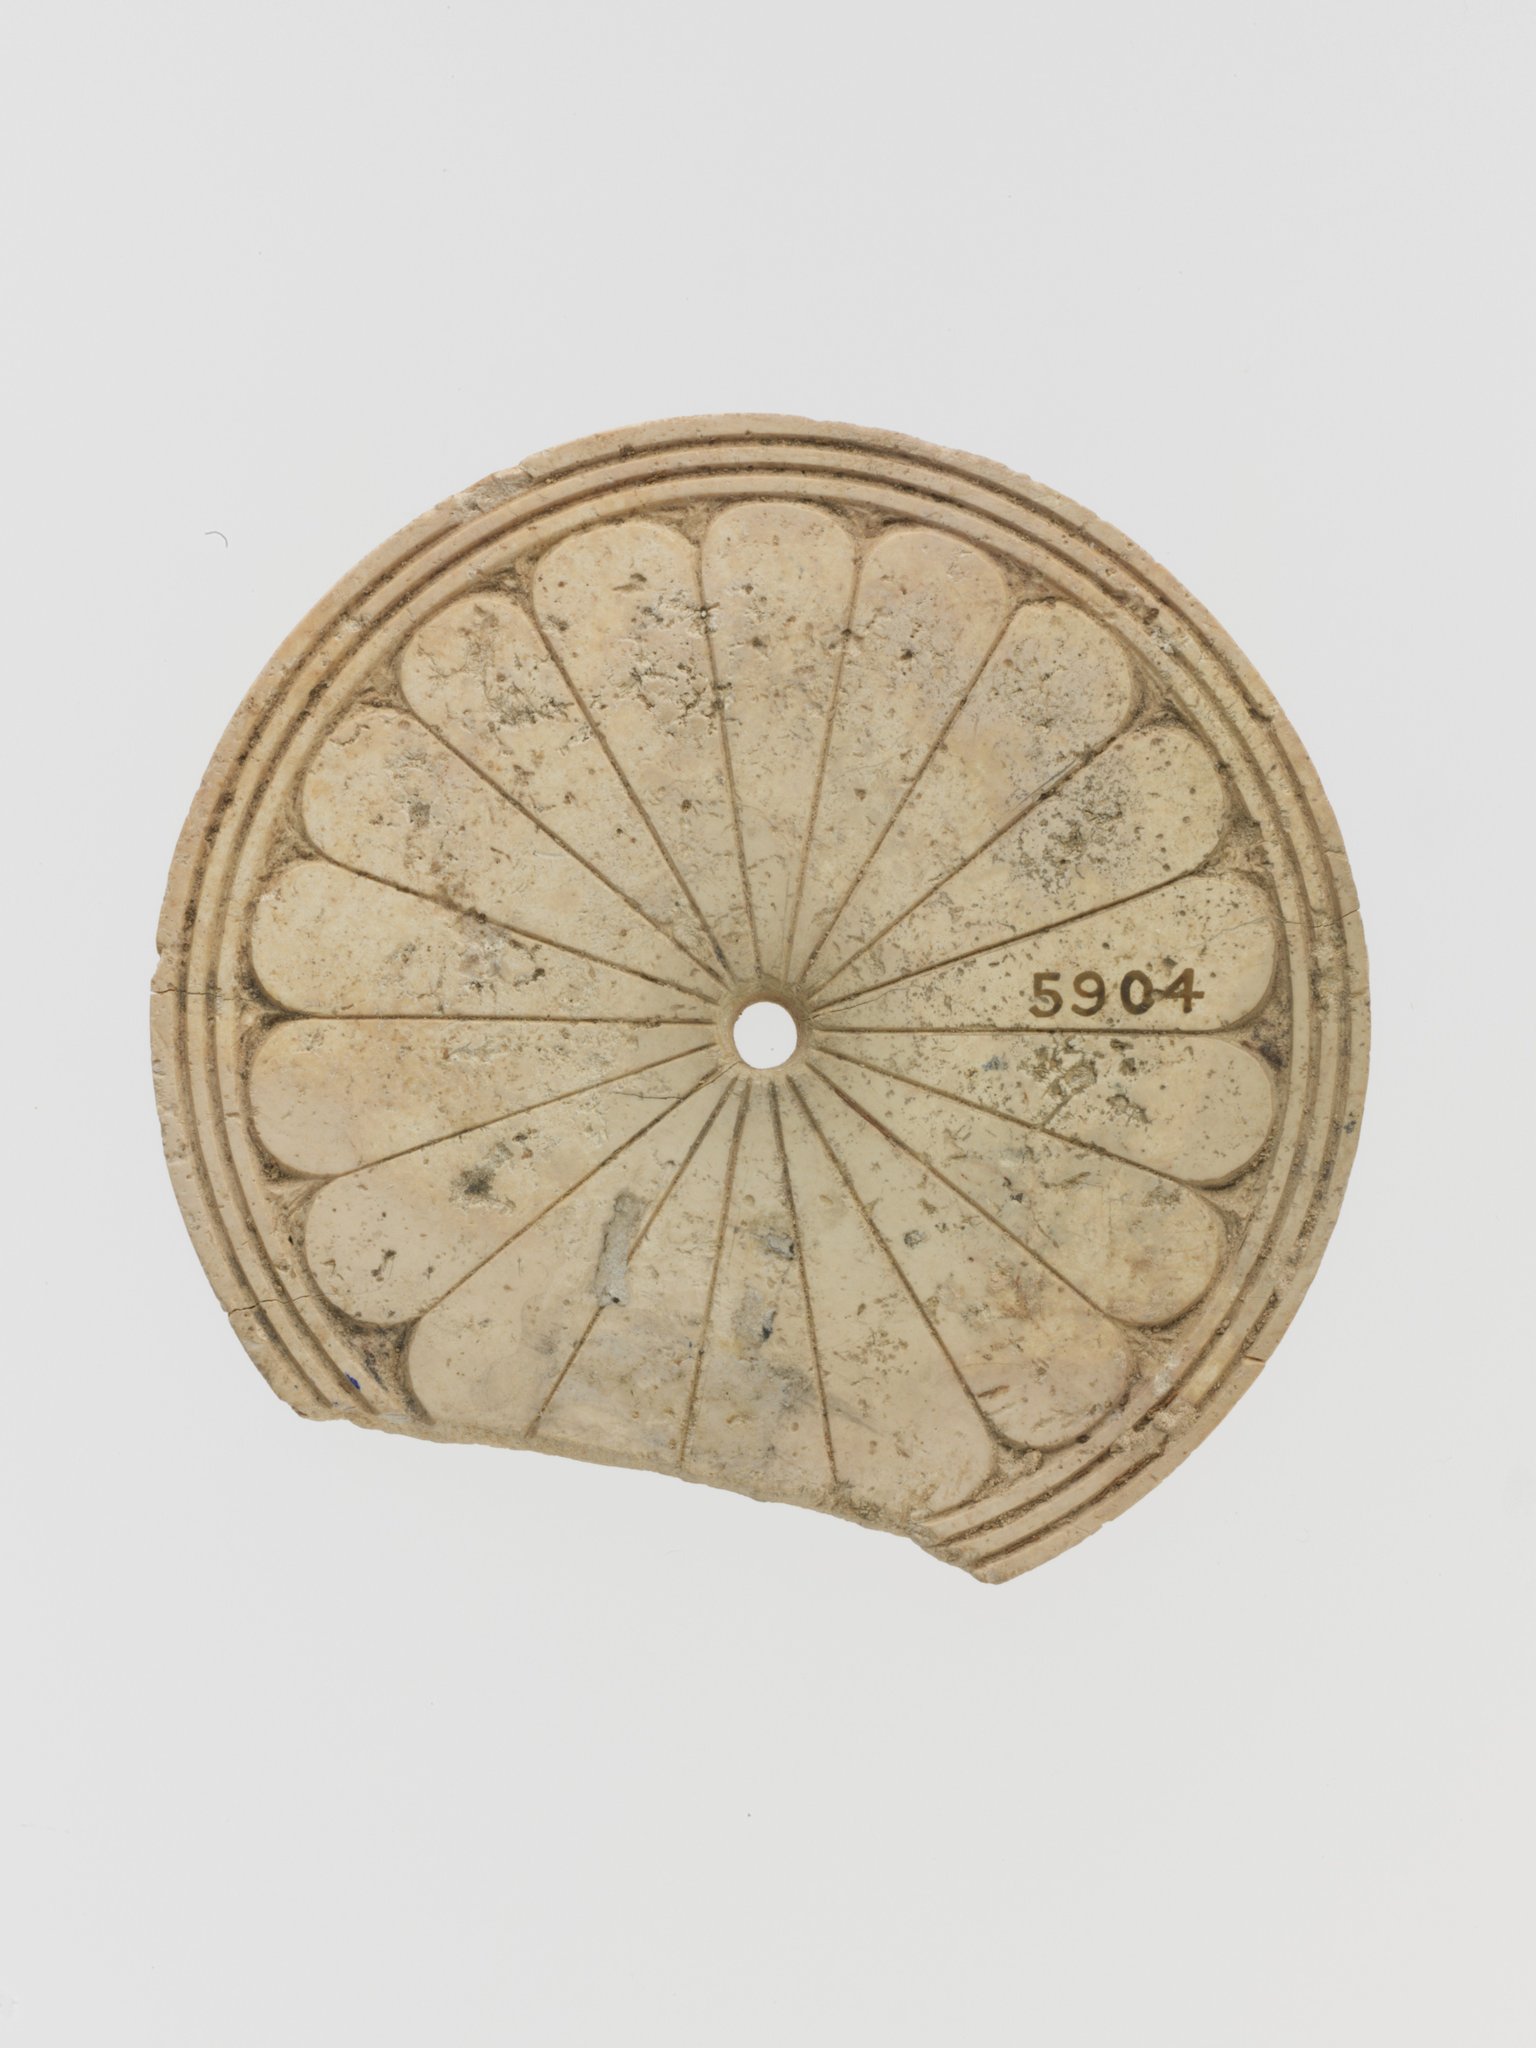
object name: roundel, disk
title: Ivory disk of a pyxis with a rosette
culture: cypriot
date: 1300-1101 BCE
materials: ivory